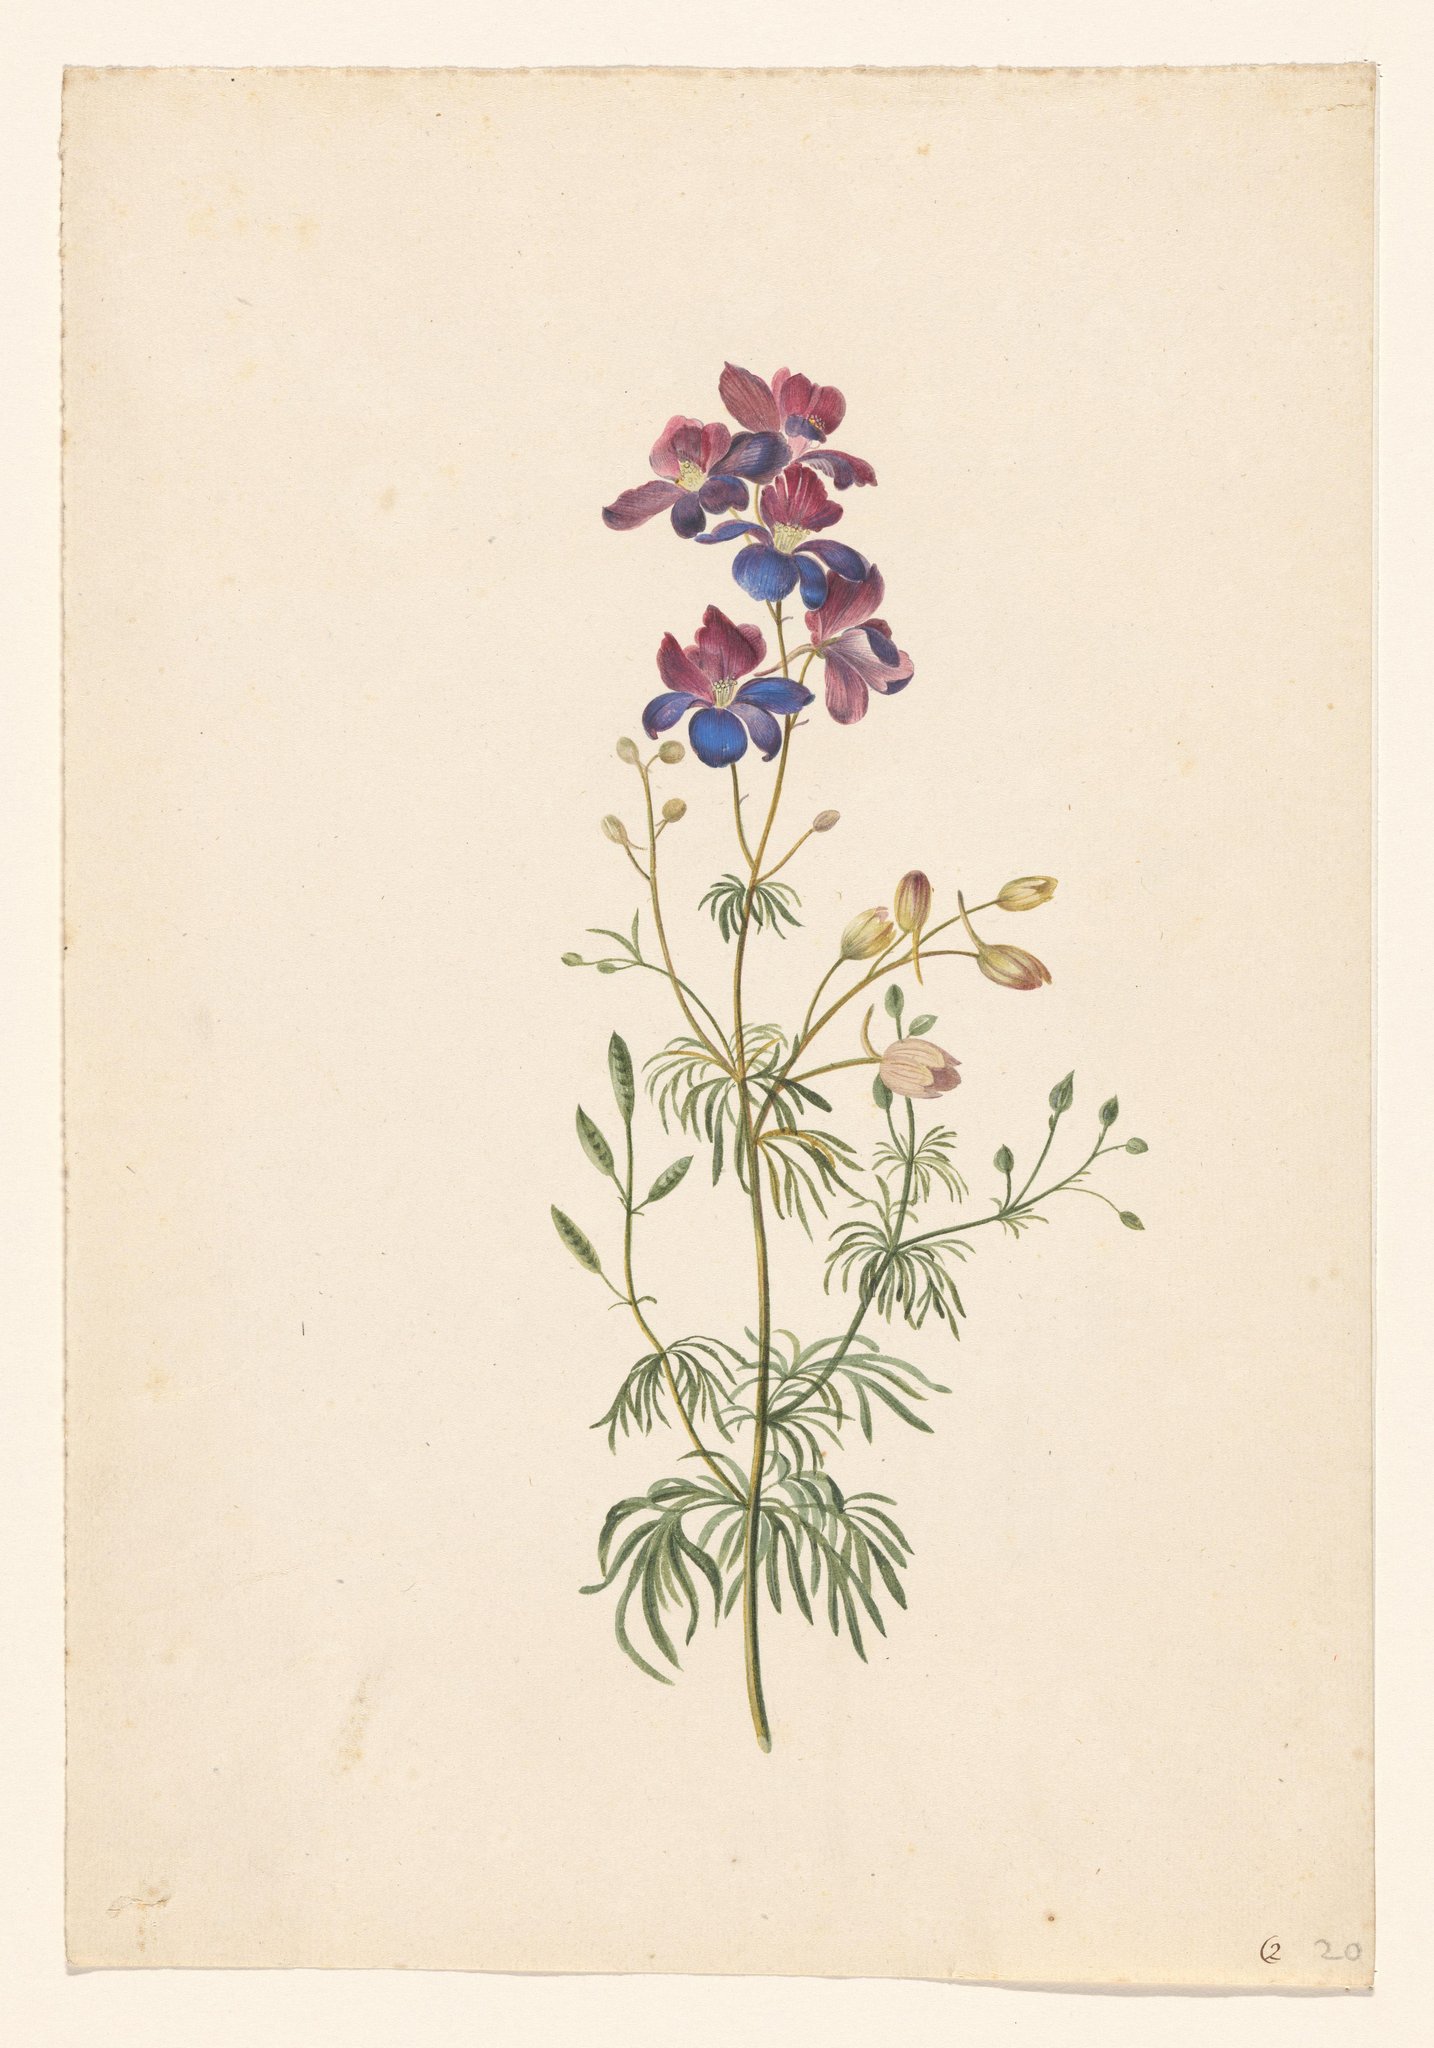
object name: drawing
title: Delphinium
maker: alida withoos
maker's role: draughtsman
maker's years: 1659-1730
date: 1670-1730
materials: paper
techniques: drawing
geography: netherlands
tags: flowers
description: The style of Withoos’ flower drawings is very consistent. She presents the isolated specimen in various stages of bloom in the centre of an otherwise blank sheet. The leaves and petals of this delphinium, for instance, overlap minimally to show all of the parts distinctly. This somewhat schematic, scientific re presentation of flowers was appreciated by botanists and collectors.